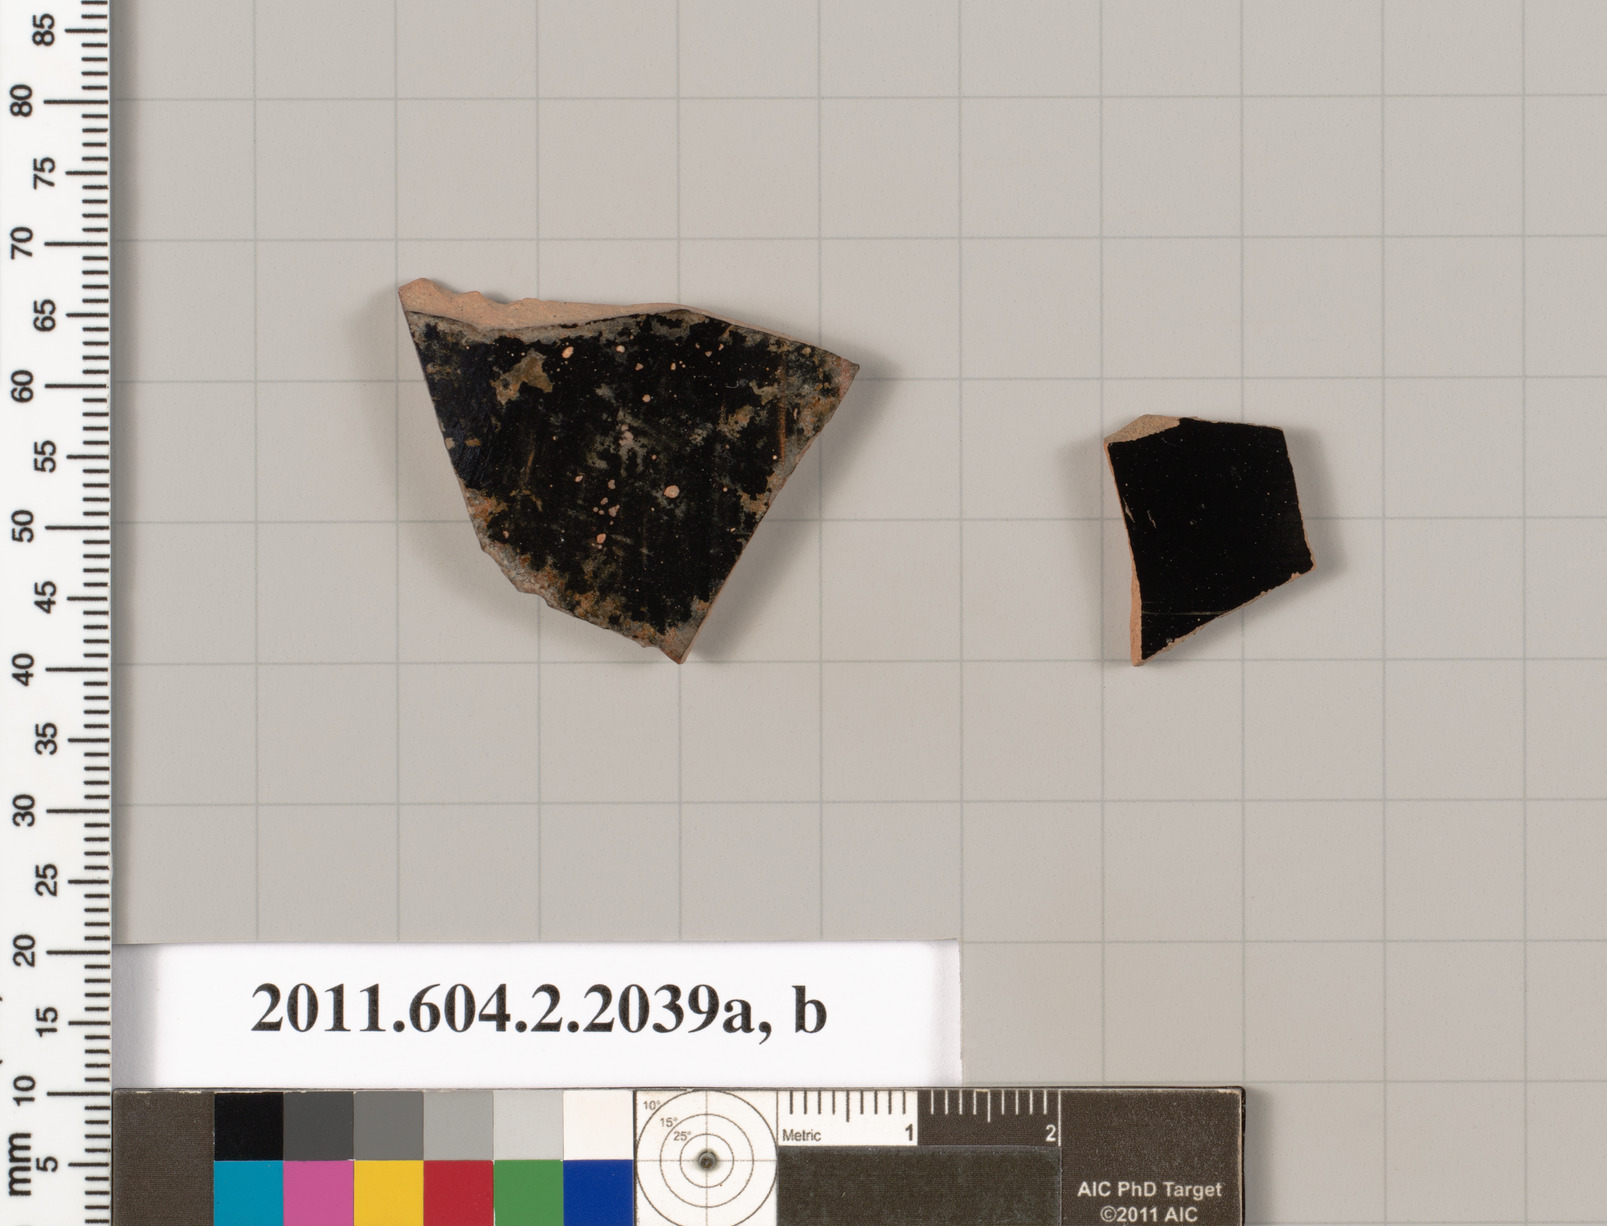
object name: pot fragment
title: Terracotta fragments of pots; unglazed on the inside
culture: greek, attic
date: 600-401 BCE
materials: terracotta